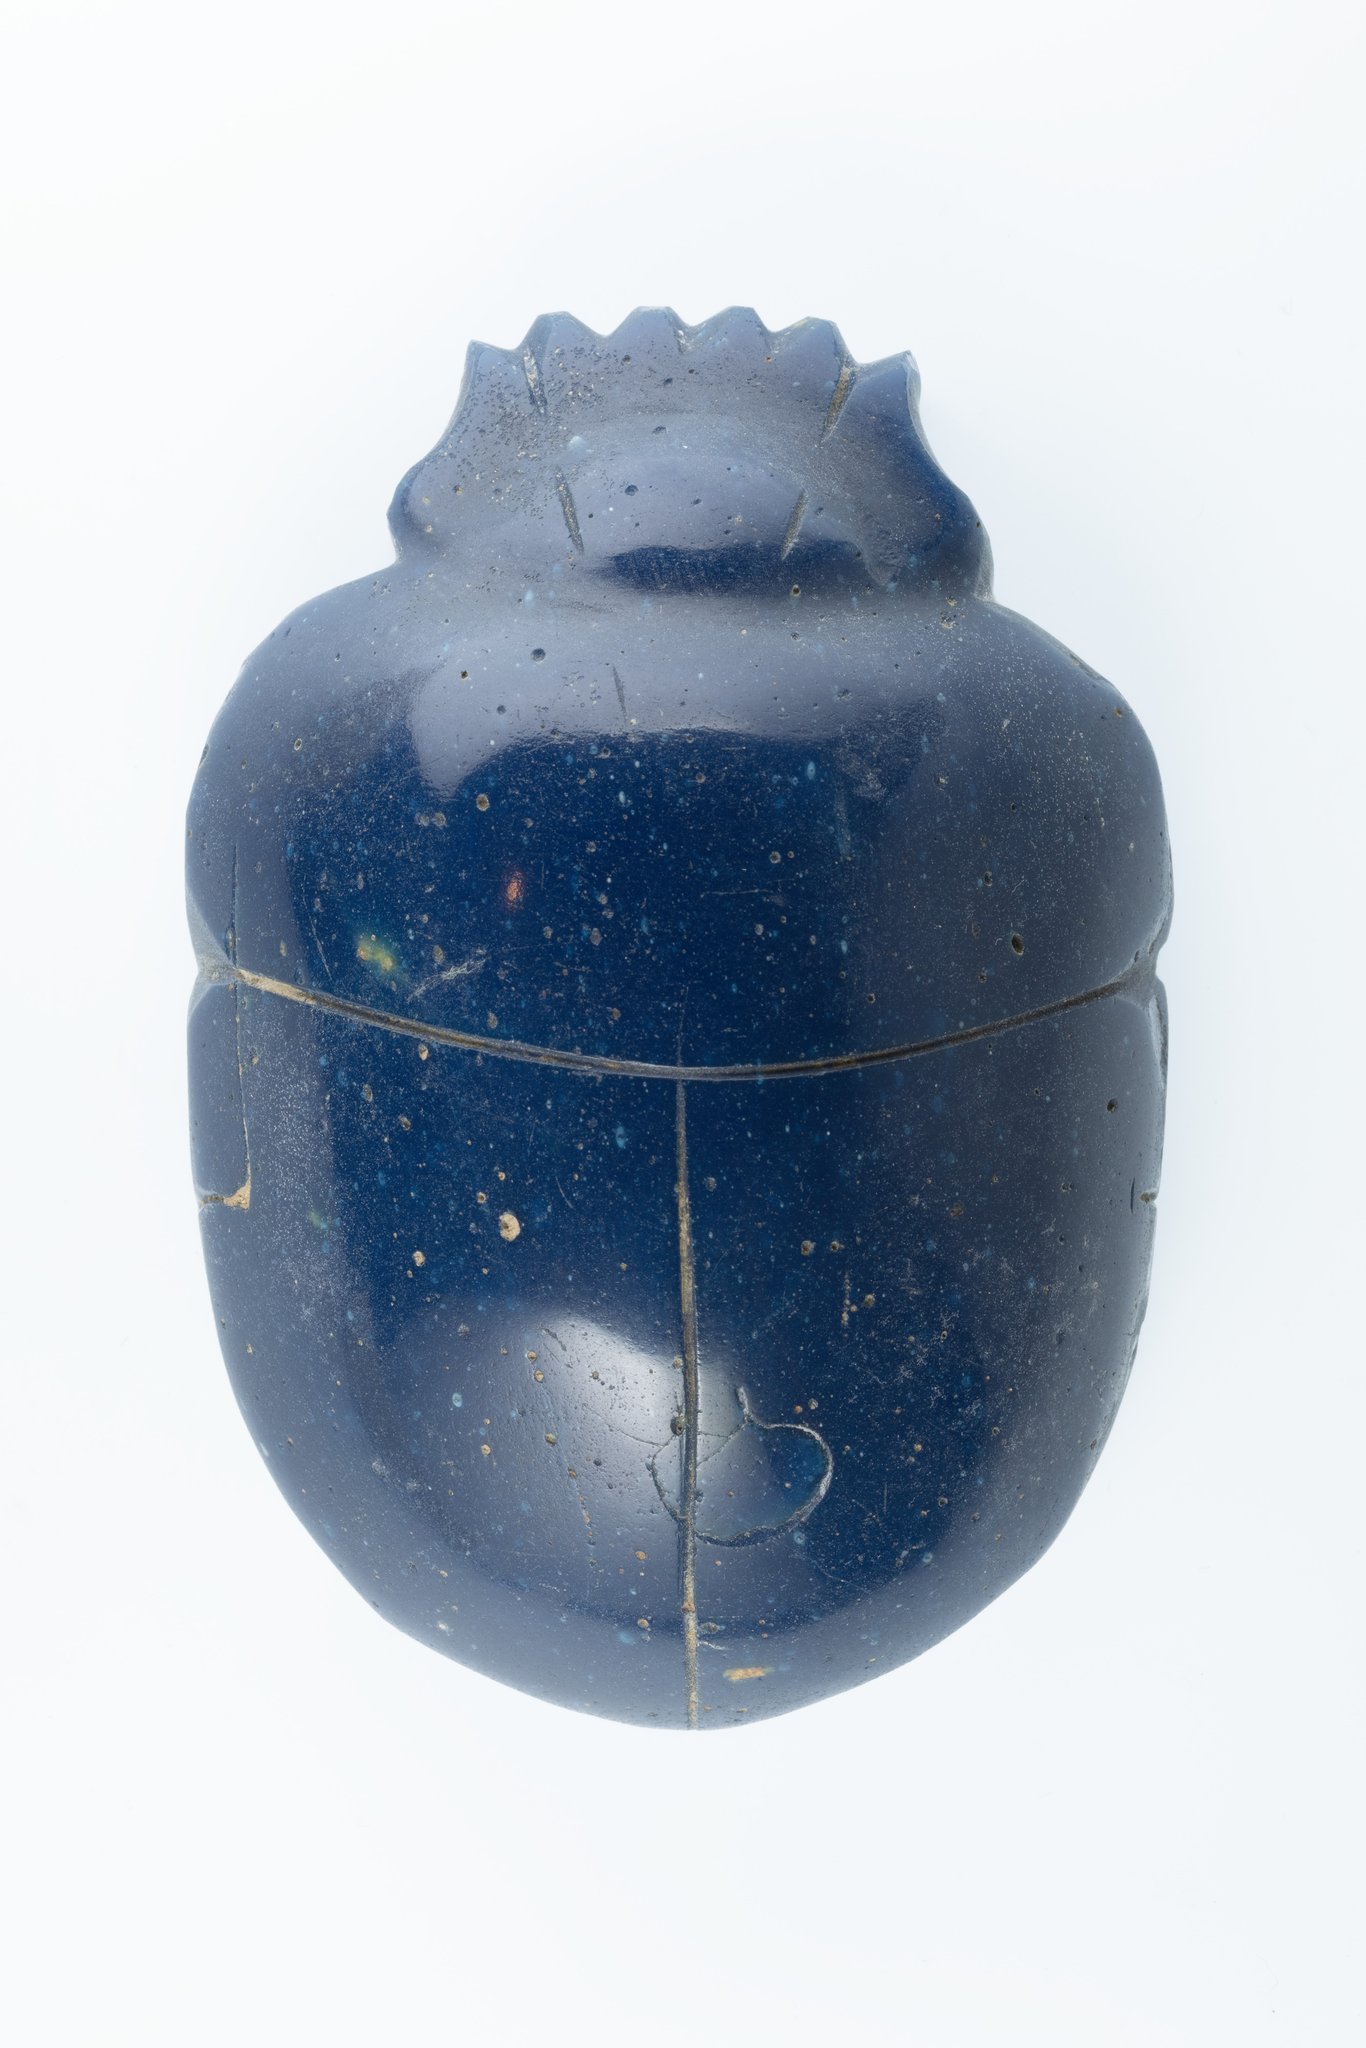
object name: scarab, inlay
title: Scarab, inlay (?)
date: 1070-343 BCE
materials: glass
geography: egypt